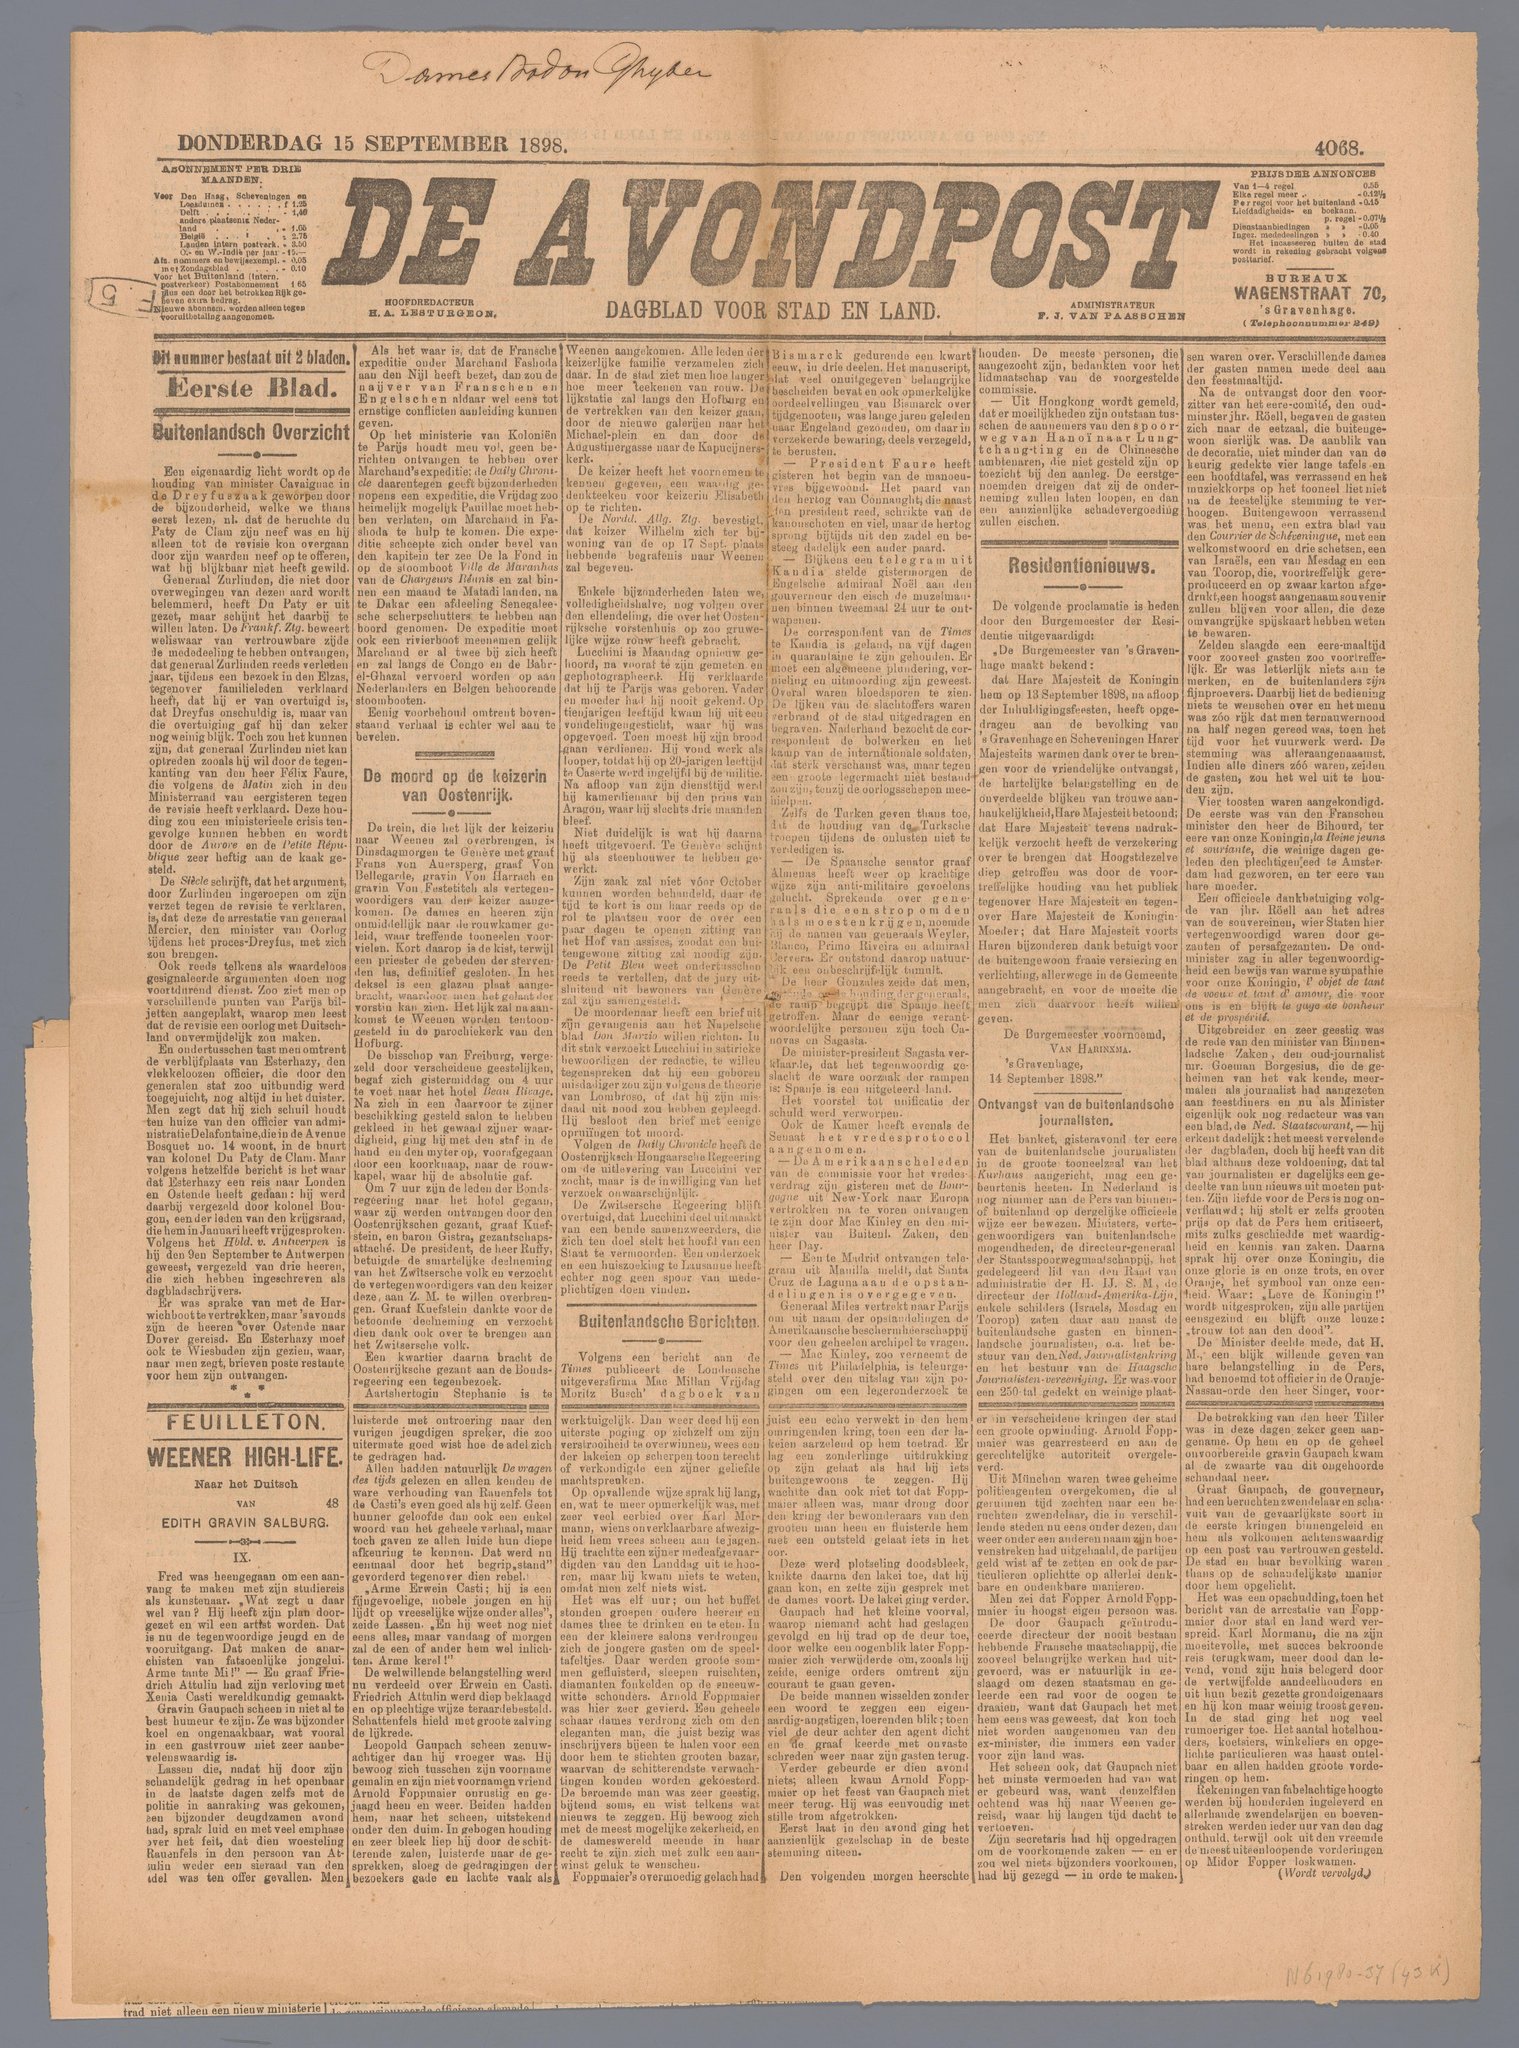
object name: newspaper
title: de Avondpost; dagblad voor stad en land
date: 1898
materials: paper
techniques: printing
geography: the hague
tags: the hague, print maker, wilhelmina of the netherlands, netherlands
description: Eén van een serie kranten, nrs. 4056 t/m 4073, van "de Avondpost" met berichten over de inhuldiging van koningin Wilhelmina 1898.